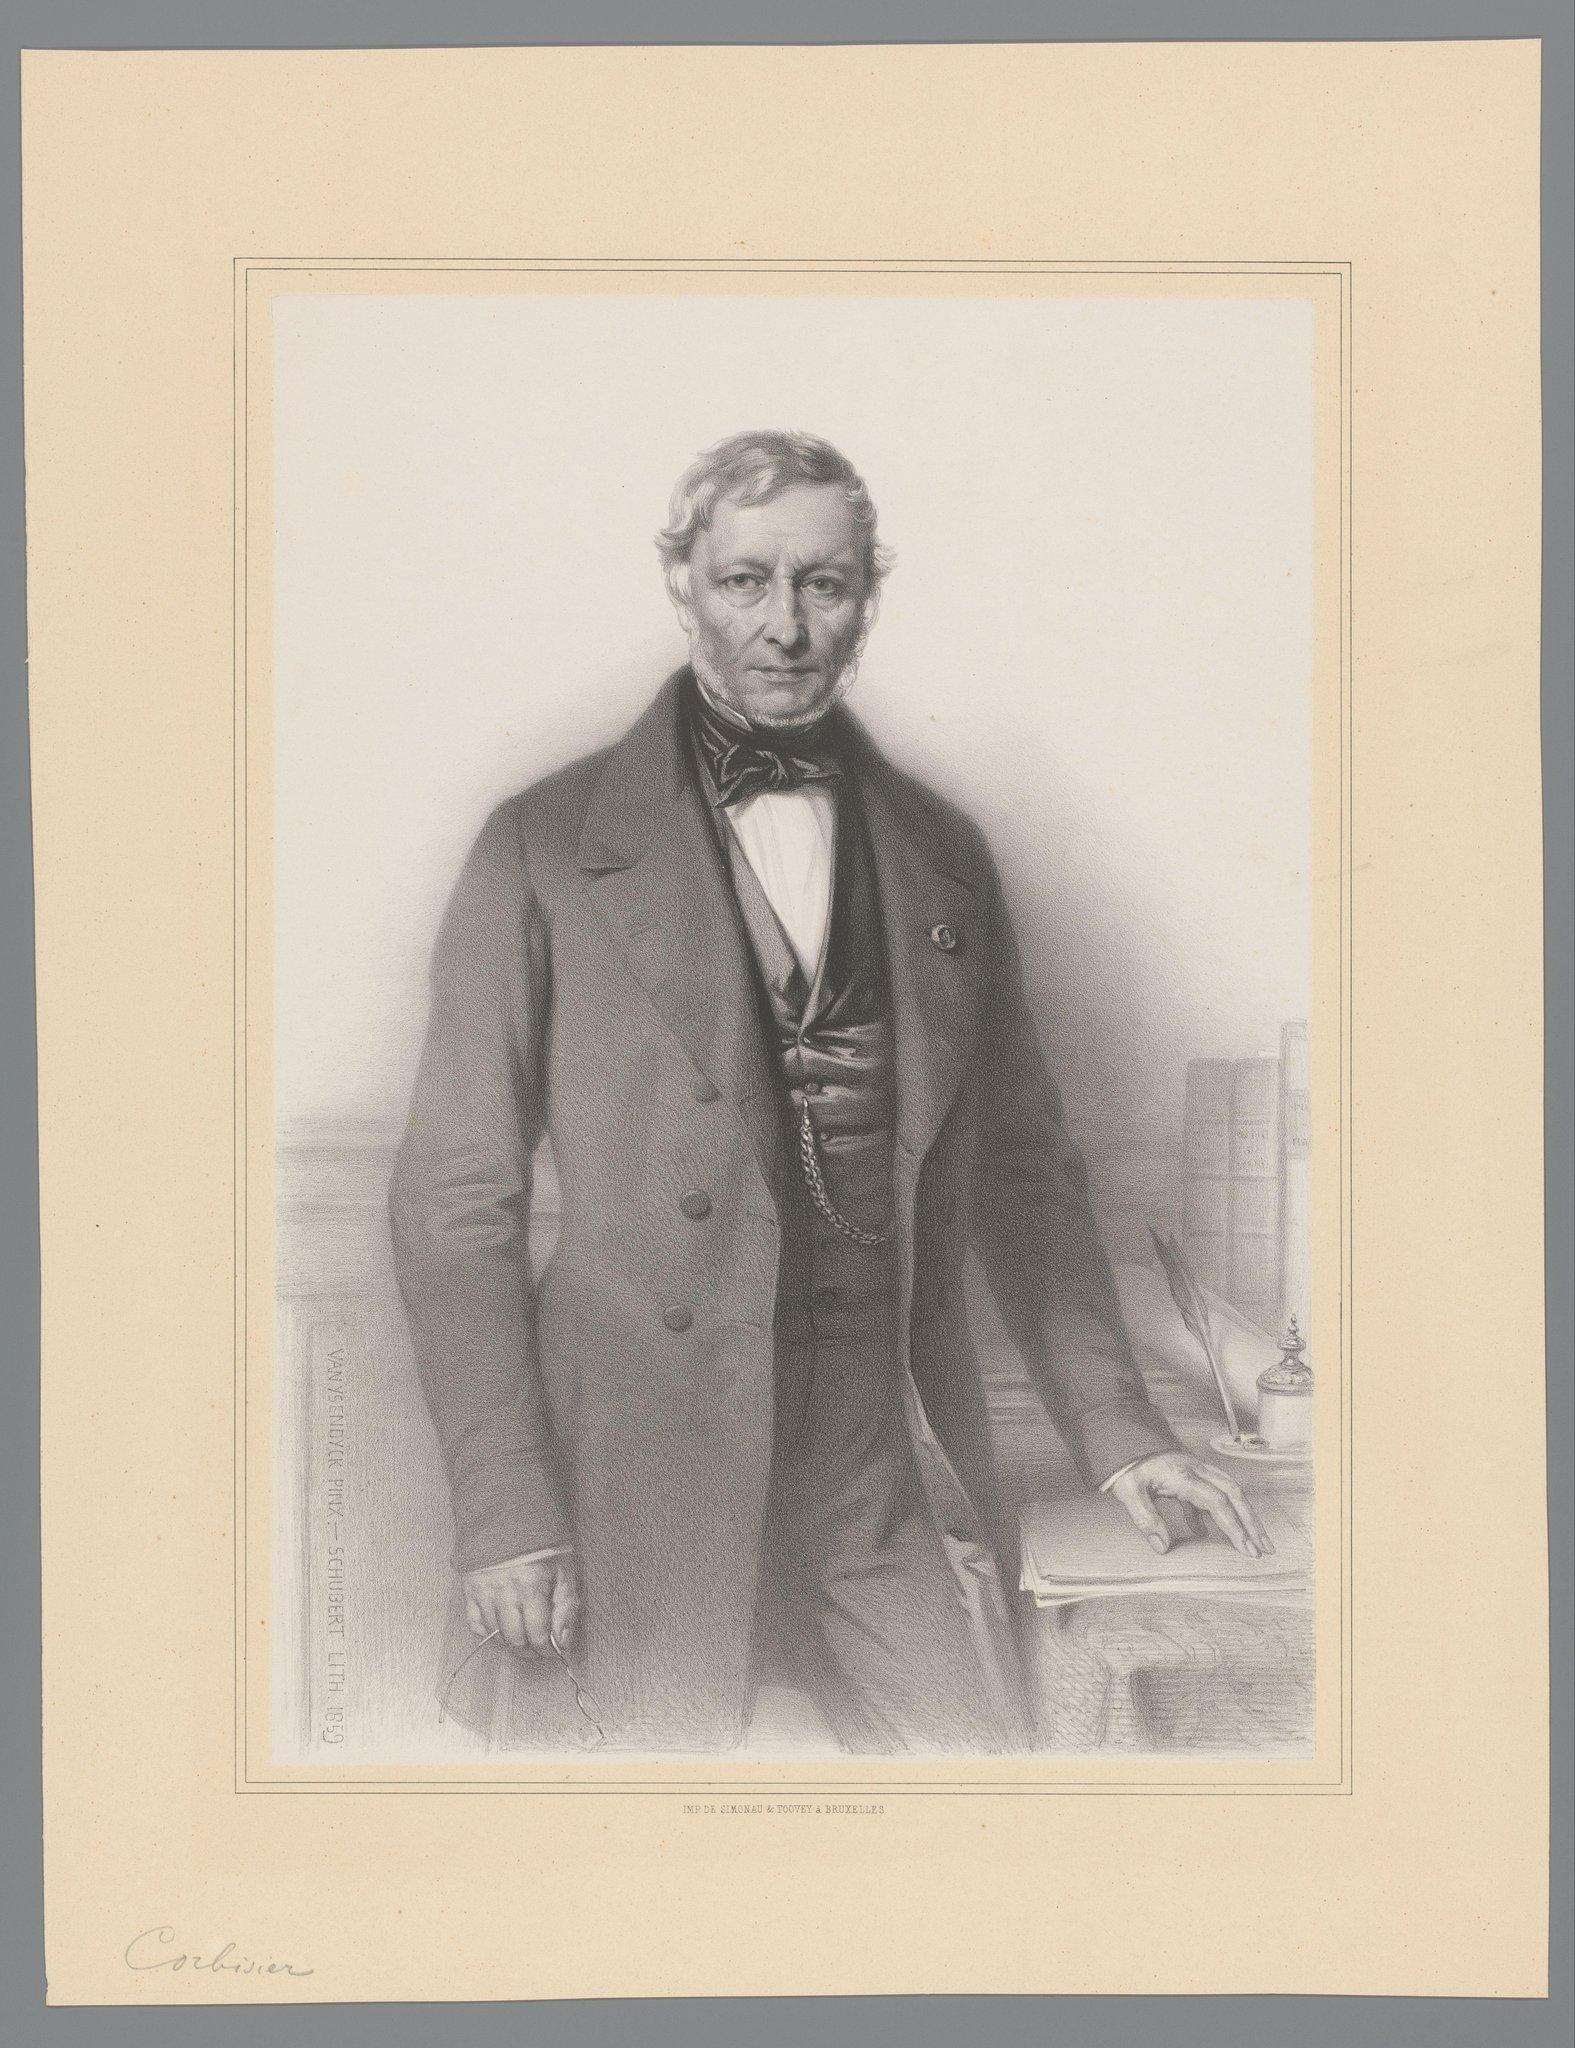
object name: print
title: Portret van mijnheer Corbisier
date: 1859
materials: paper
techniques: lithograph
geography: brussels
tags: historical persons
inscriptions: collector's mark: Lugt 2228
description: Portret van een man met de achternaam Corbisier.